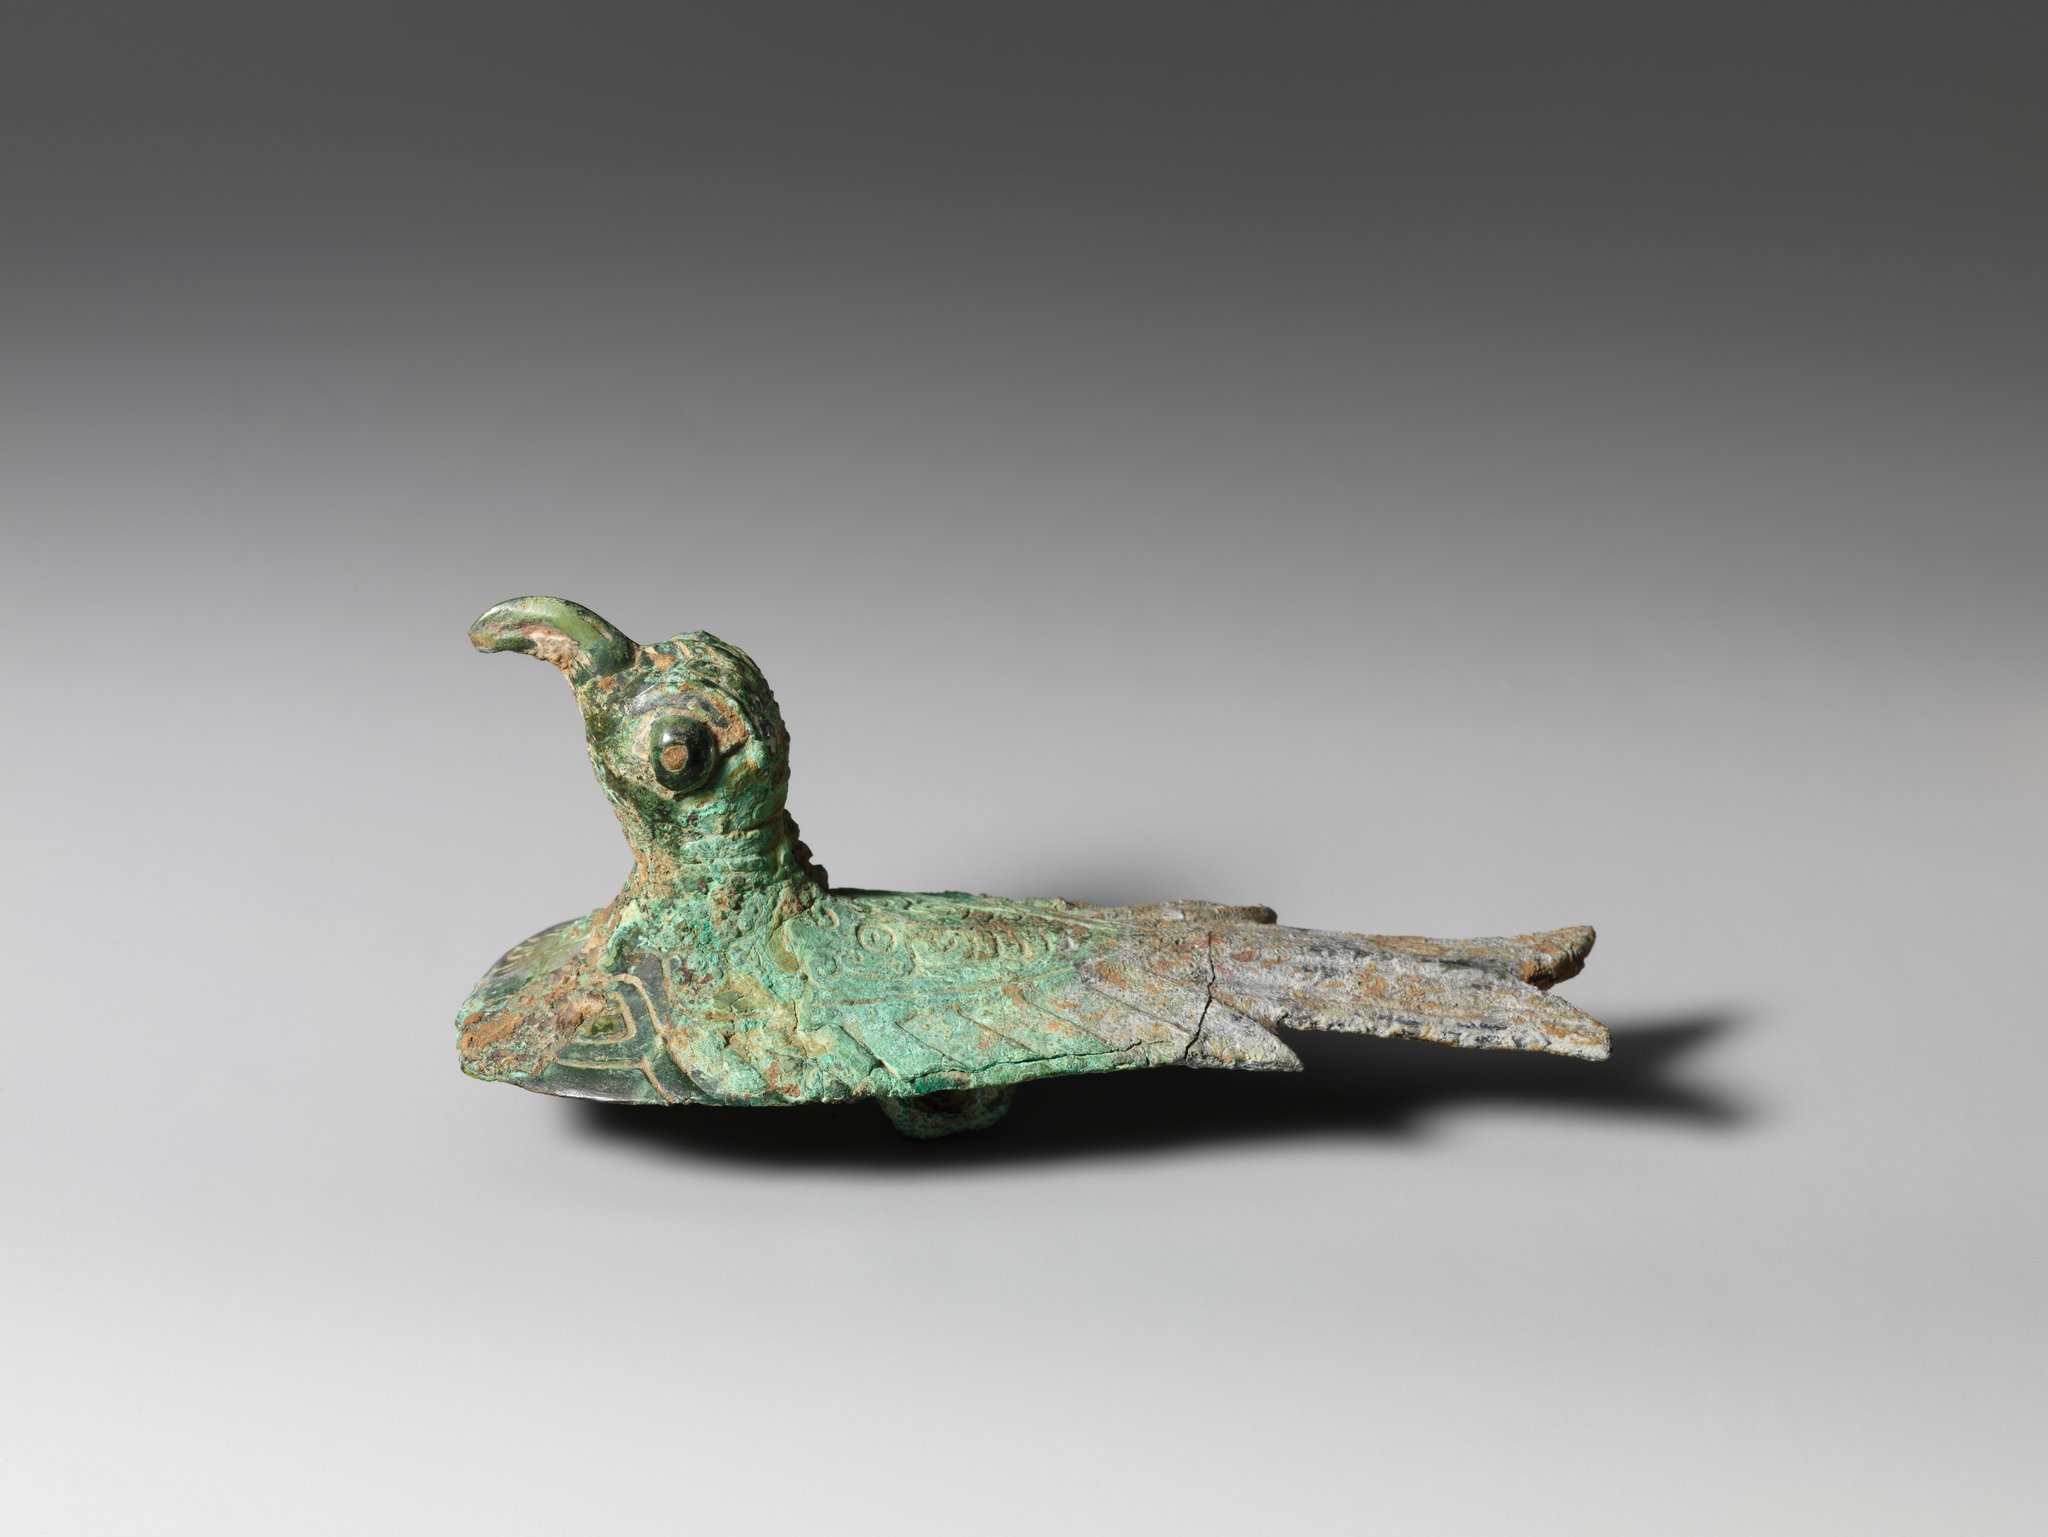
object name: fitting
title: Fitting in the Shape of a Bird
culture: chinese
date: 1100-901 BCE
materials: bronze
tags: birds